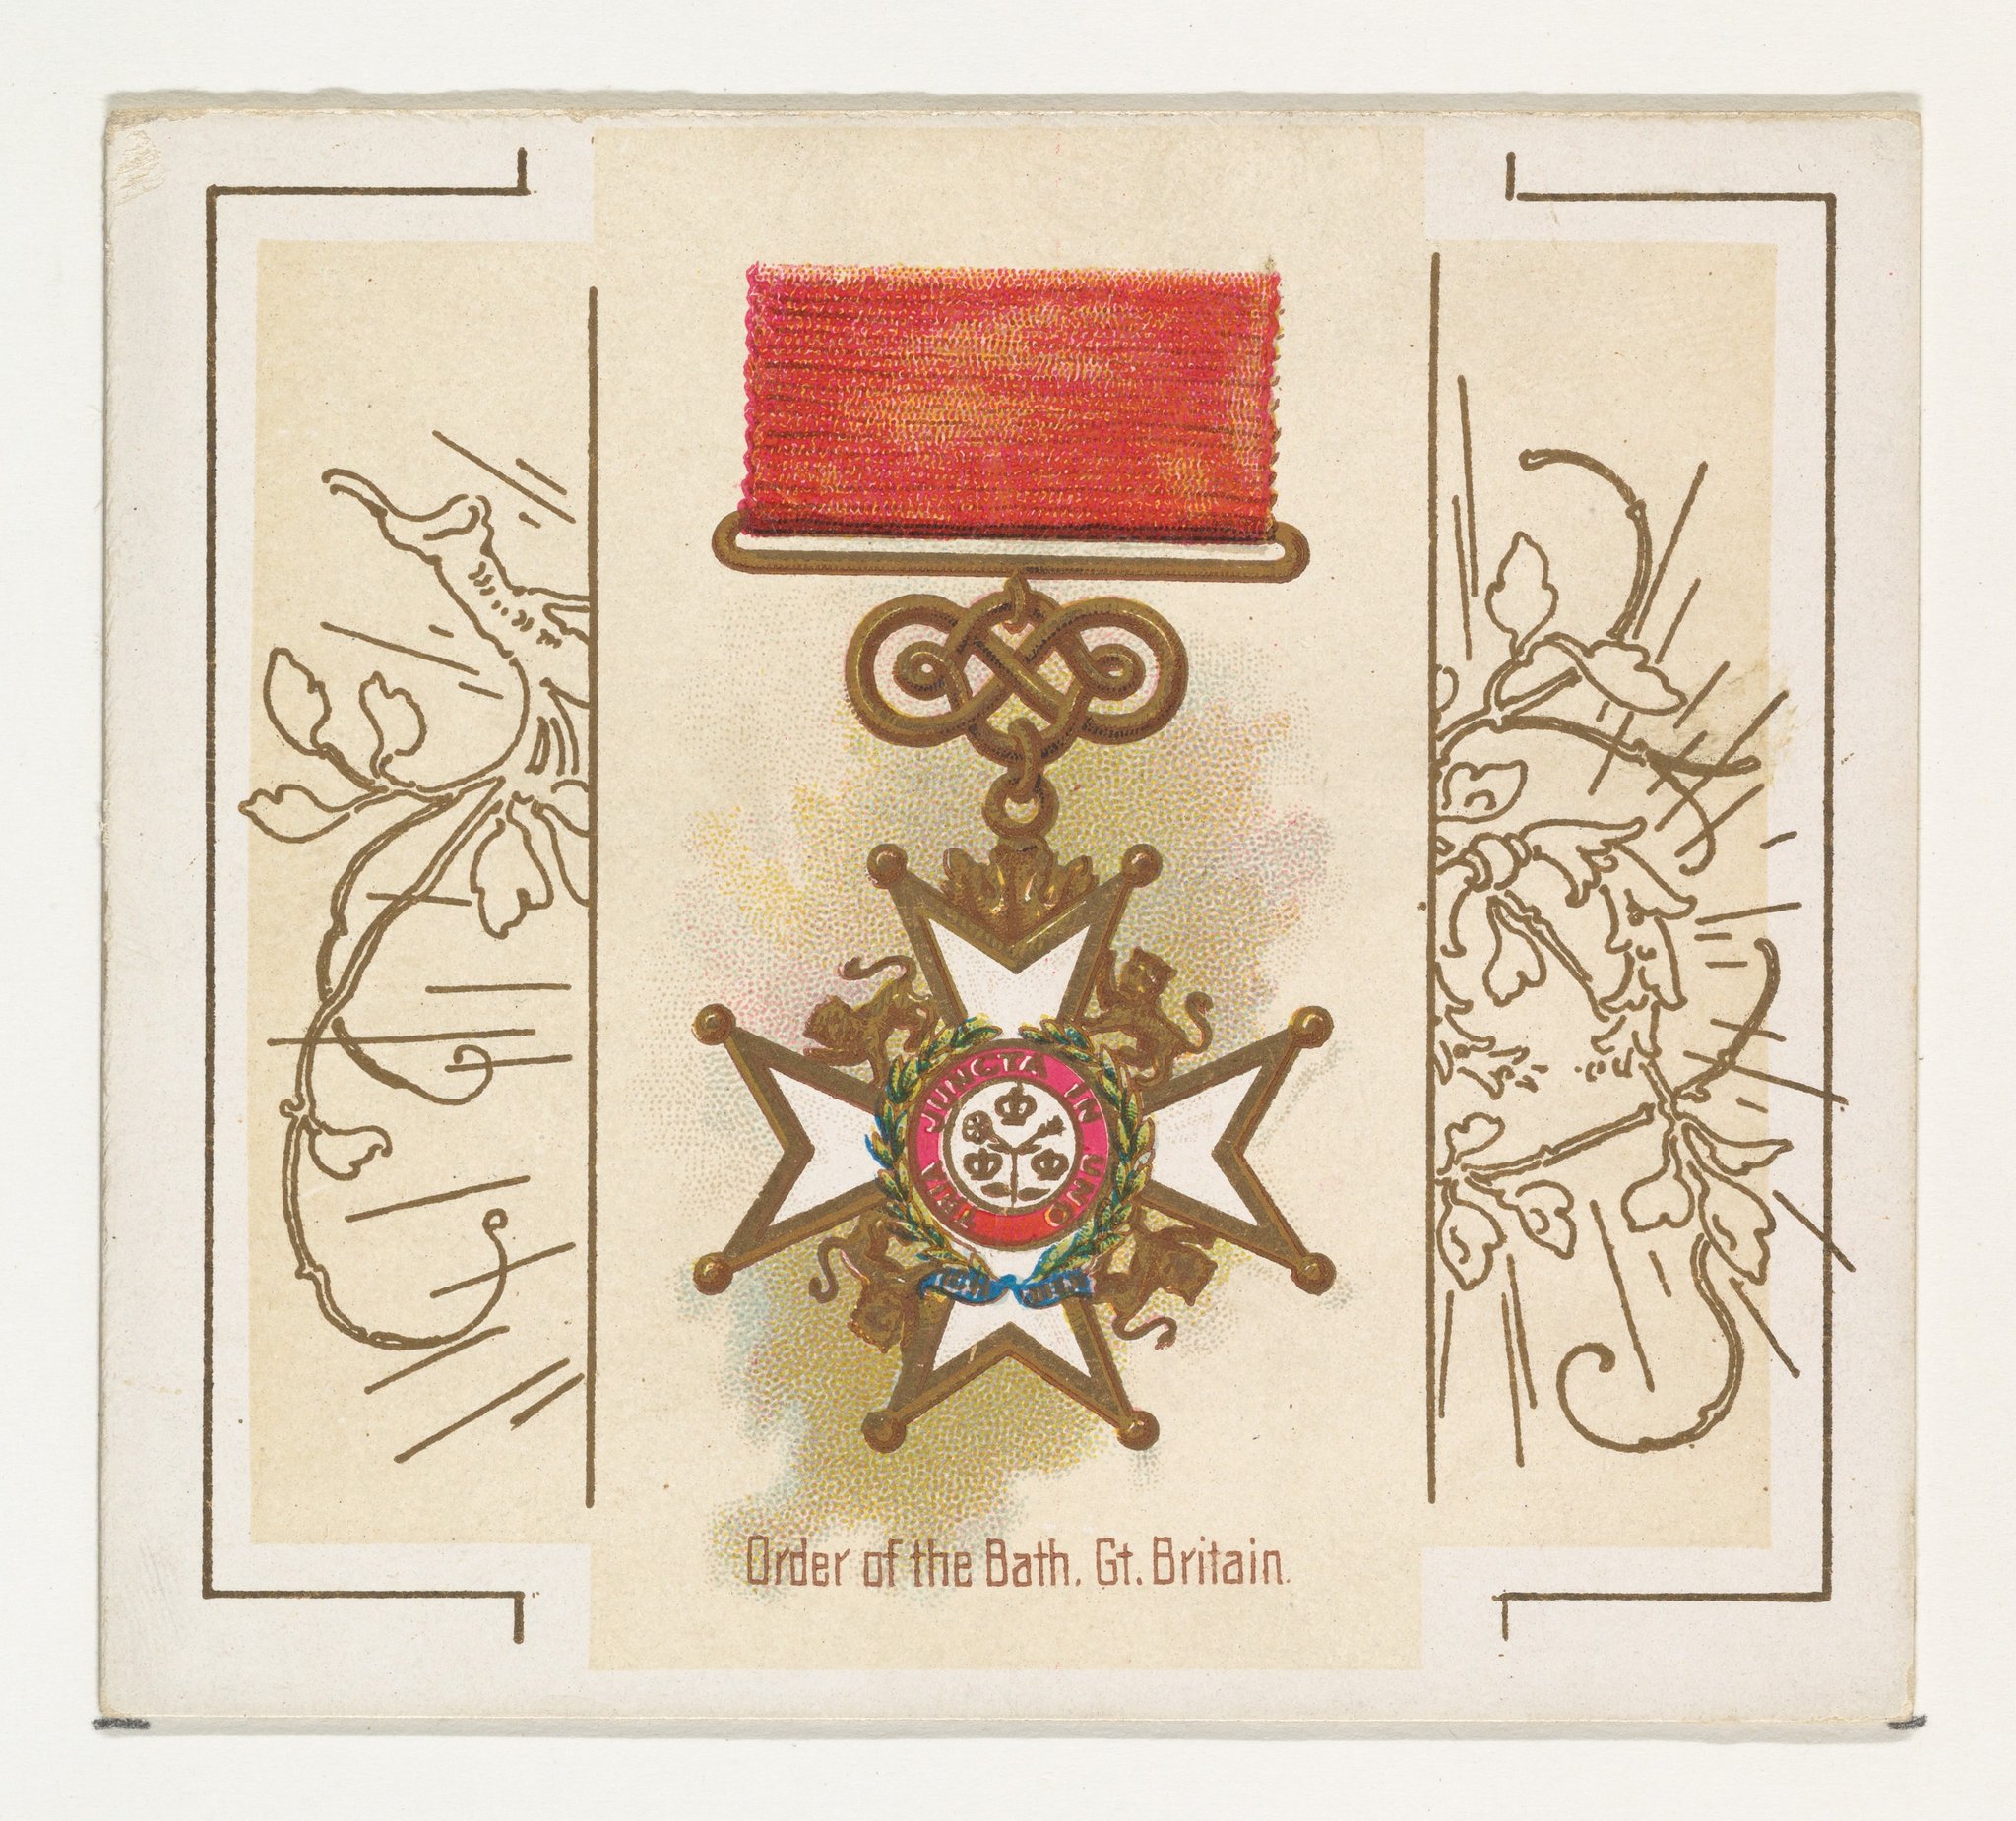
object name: print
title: Order of the Bath, Great Britain, from the World's Decorations series (N44) for Allen & Ginter Cigarettes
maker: allen & ginter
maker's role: publisher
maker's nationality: american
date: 1890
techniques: color lithograph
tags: medals